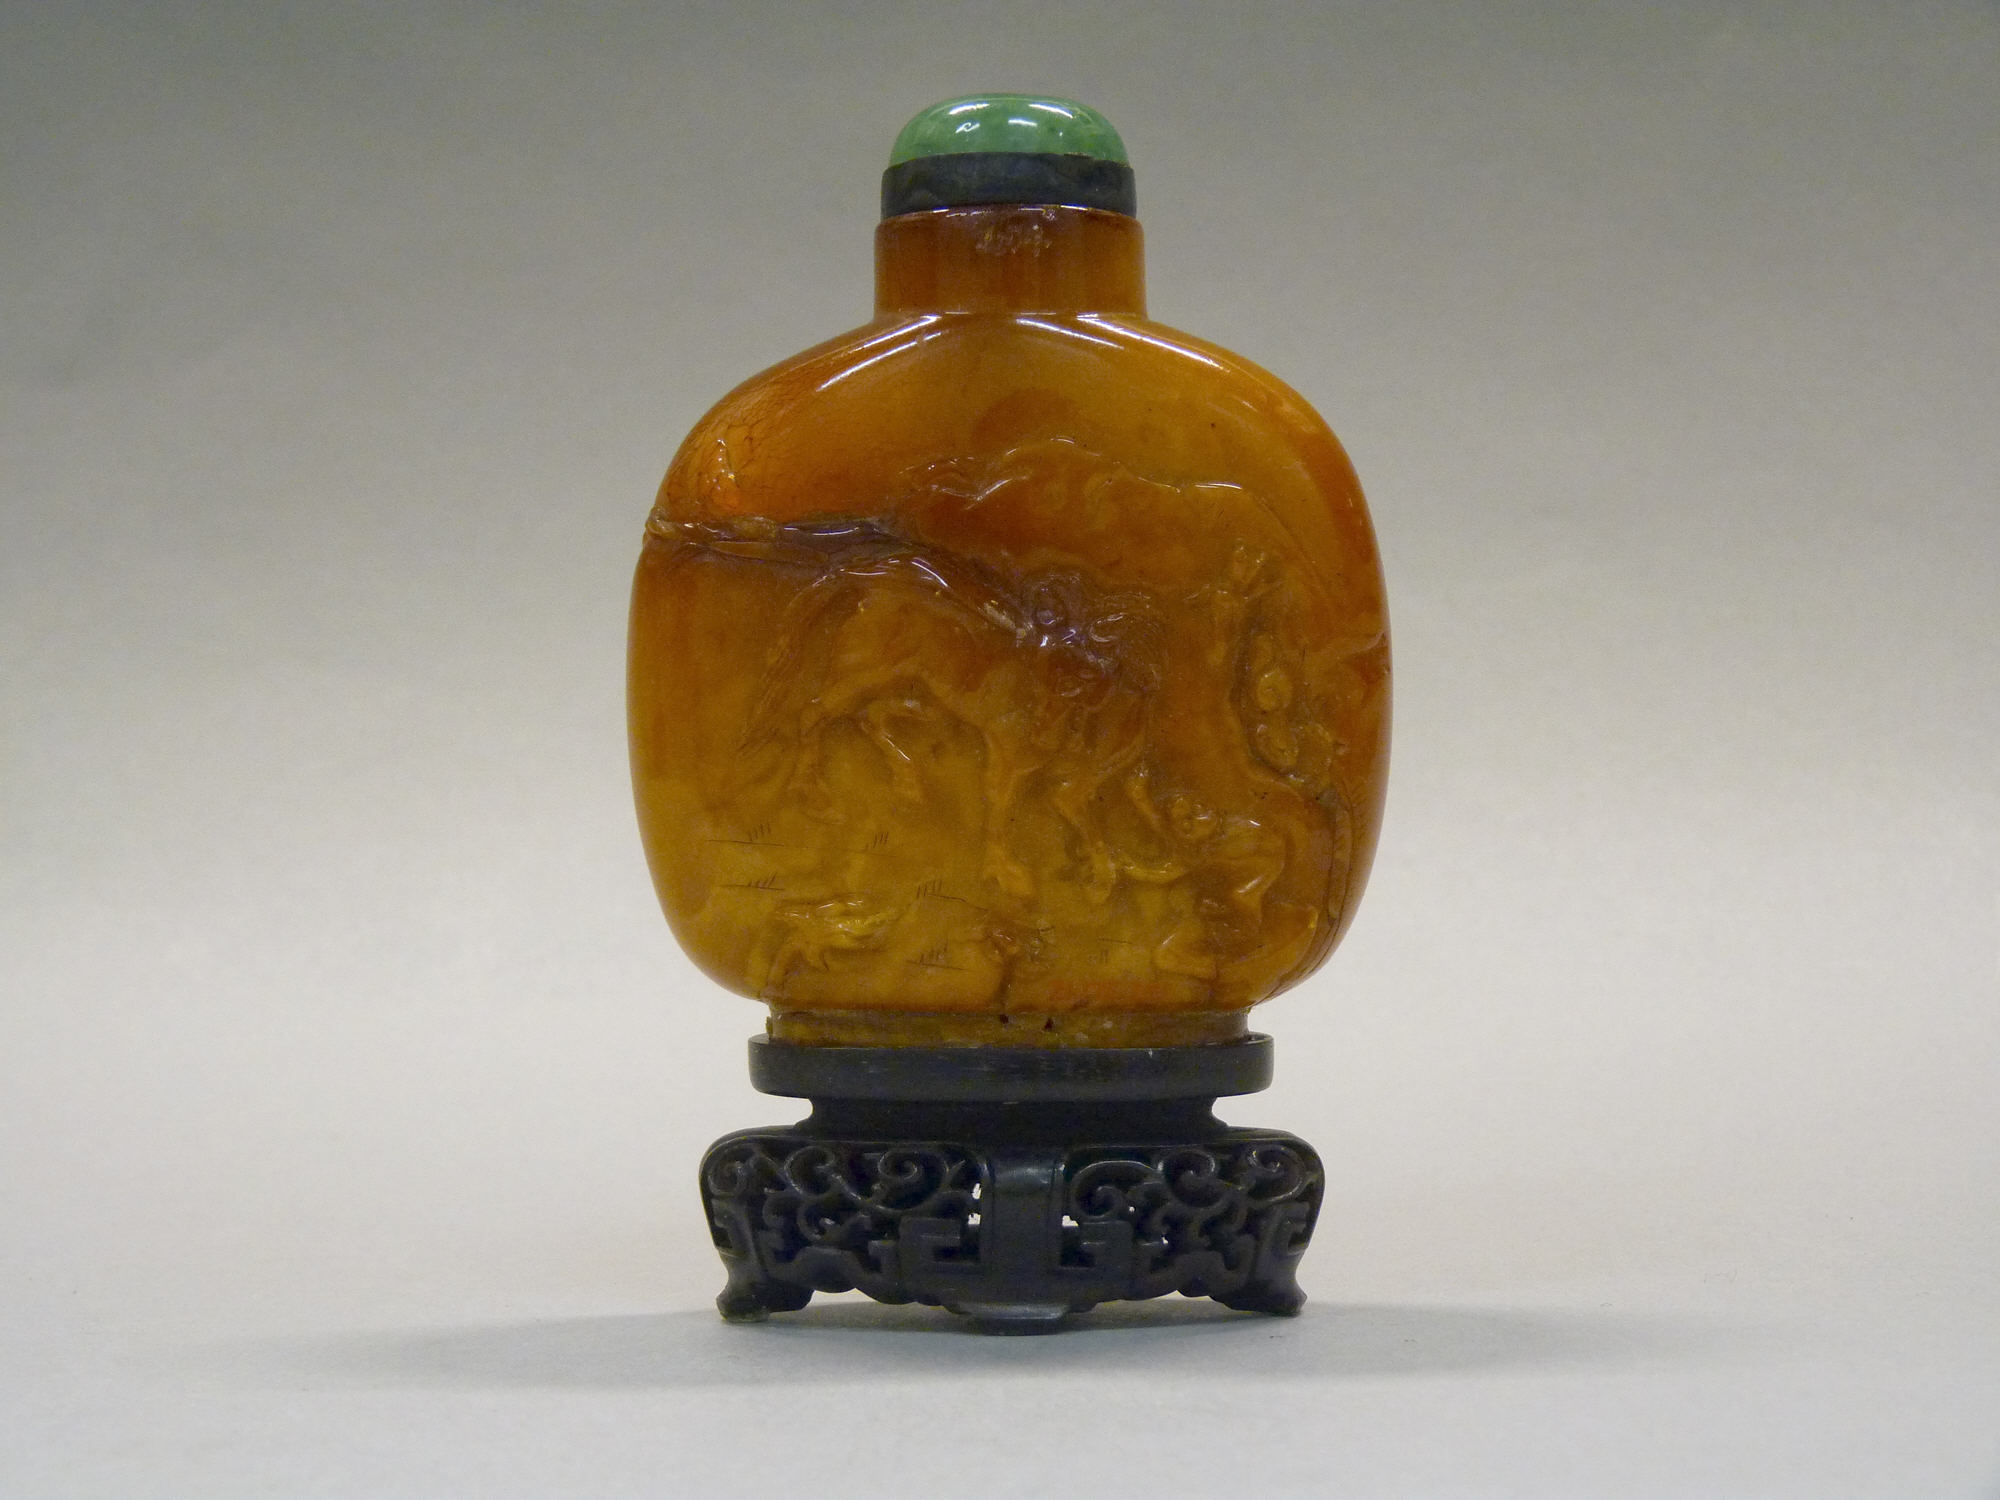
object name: snuff bottle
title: Snuff Bottle with Stopper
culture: chinese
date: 1736-1795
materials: amber, jade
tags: horses